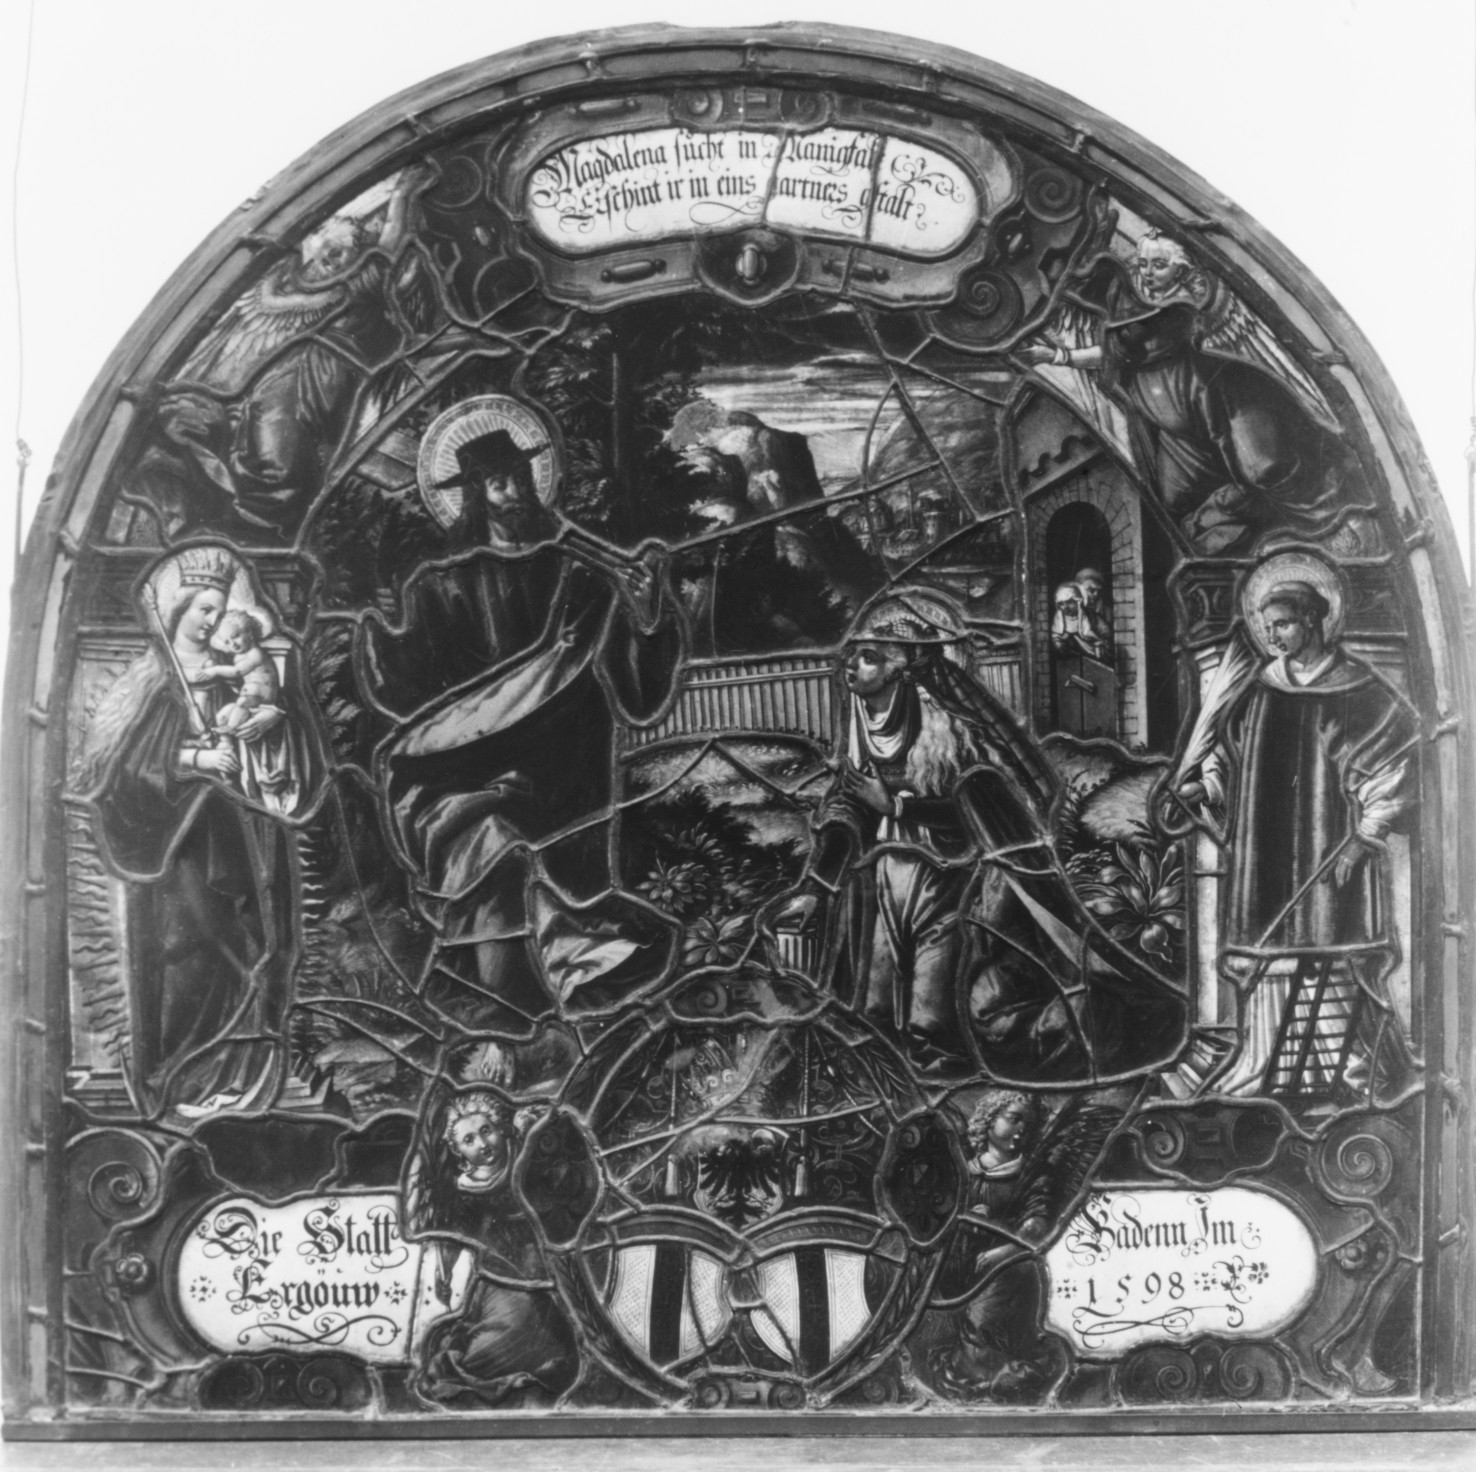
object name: panel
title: Noli Me Tangere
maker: franz fallenter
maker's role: artist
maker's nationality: german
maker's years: 1550-1616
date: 1598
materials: glass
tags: men,angels,madonna and child,coat of arms